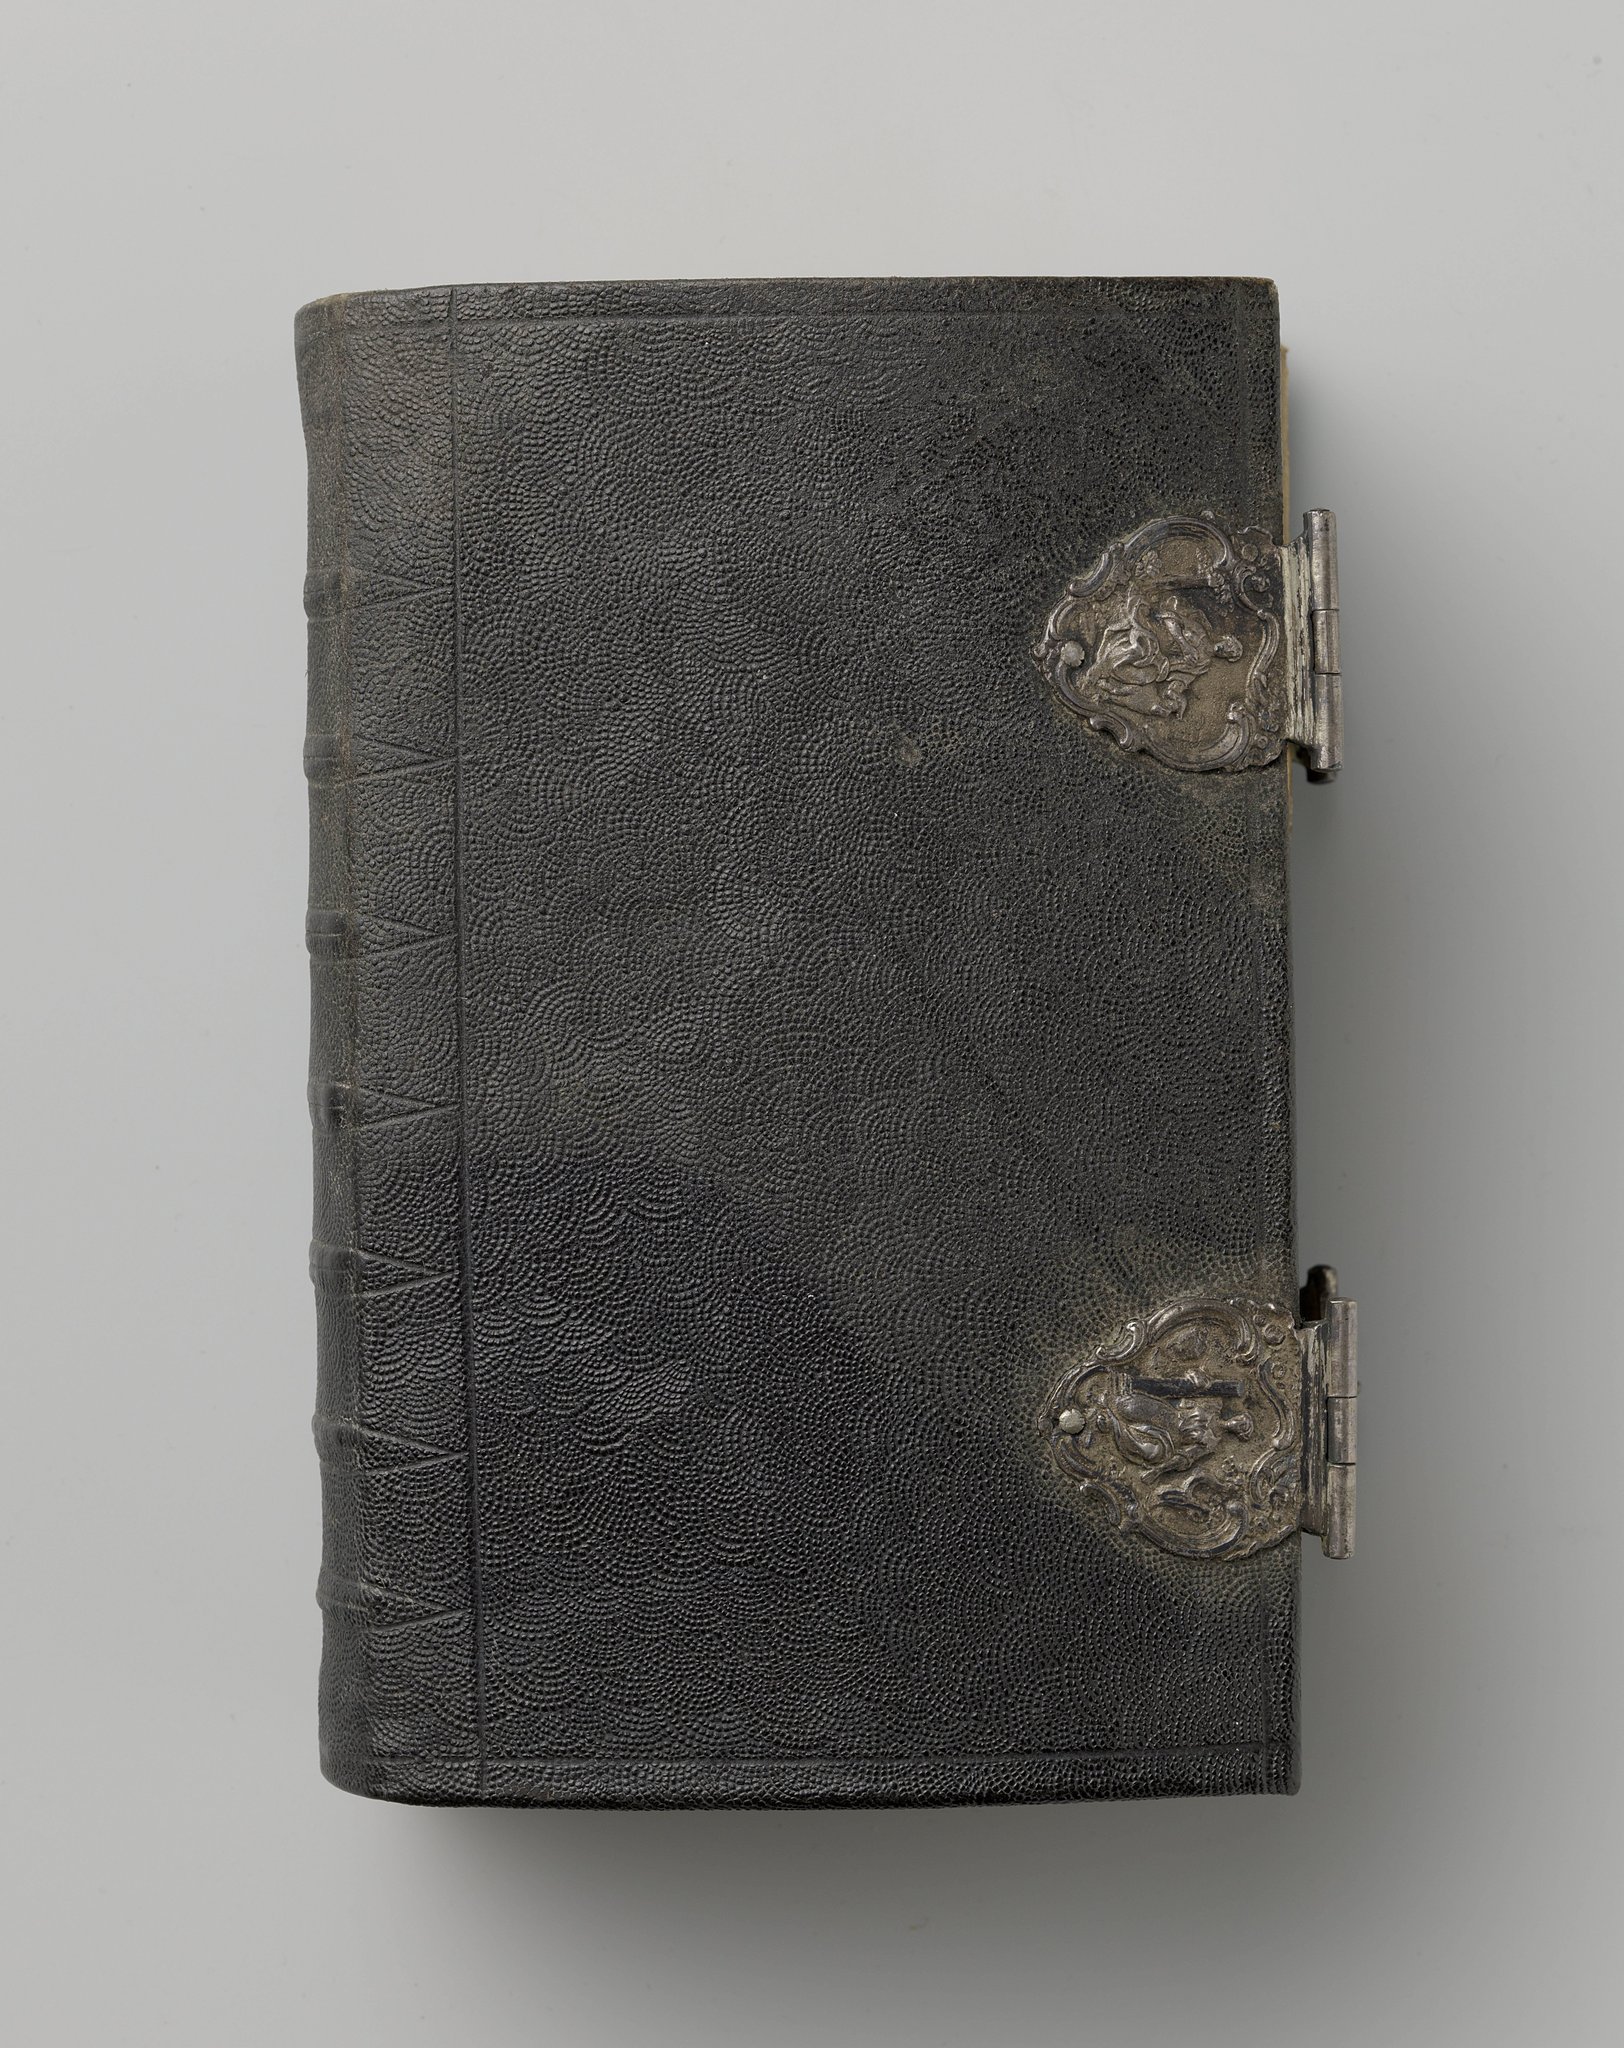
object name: service book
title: Kerk- en psalmboek in segrijnen band en met zilveren sloten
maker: Anonymous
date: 1700-1800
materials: paper, skin, silver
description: Kerk- en psalmboek in segrijnen band en met zilveren sloten, waarop in zes gedreven vrouwenfiguren de hoofddeugden zijn voorgesteld.